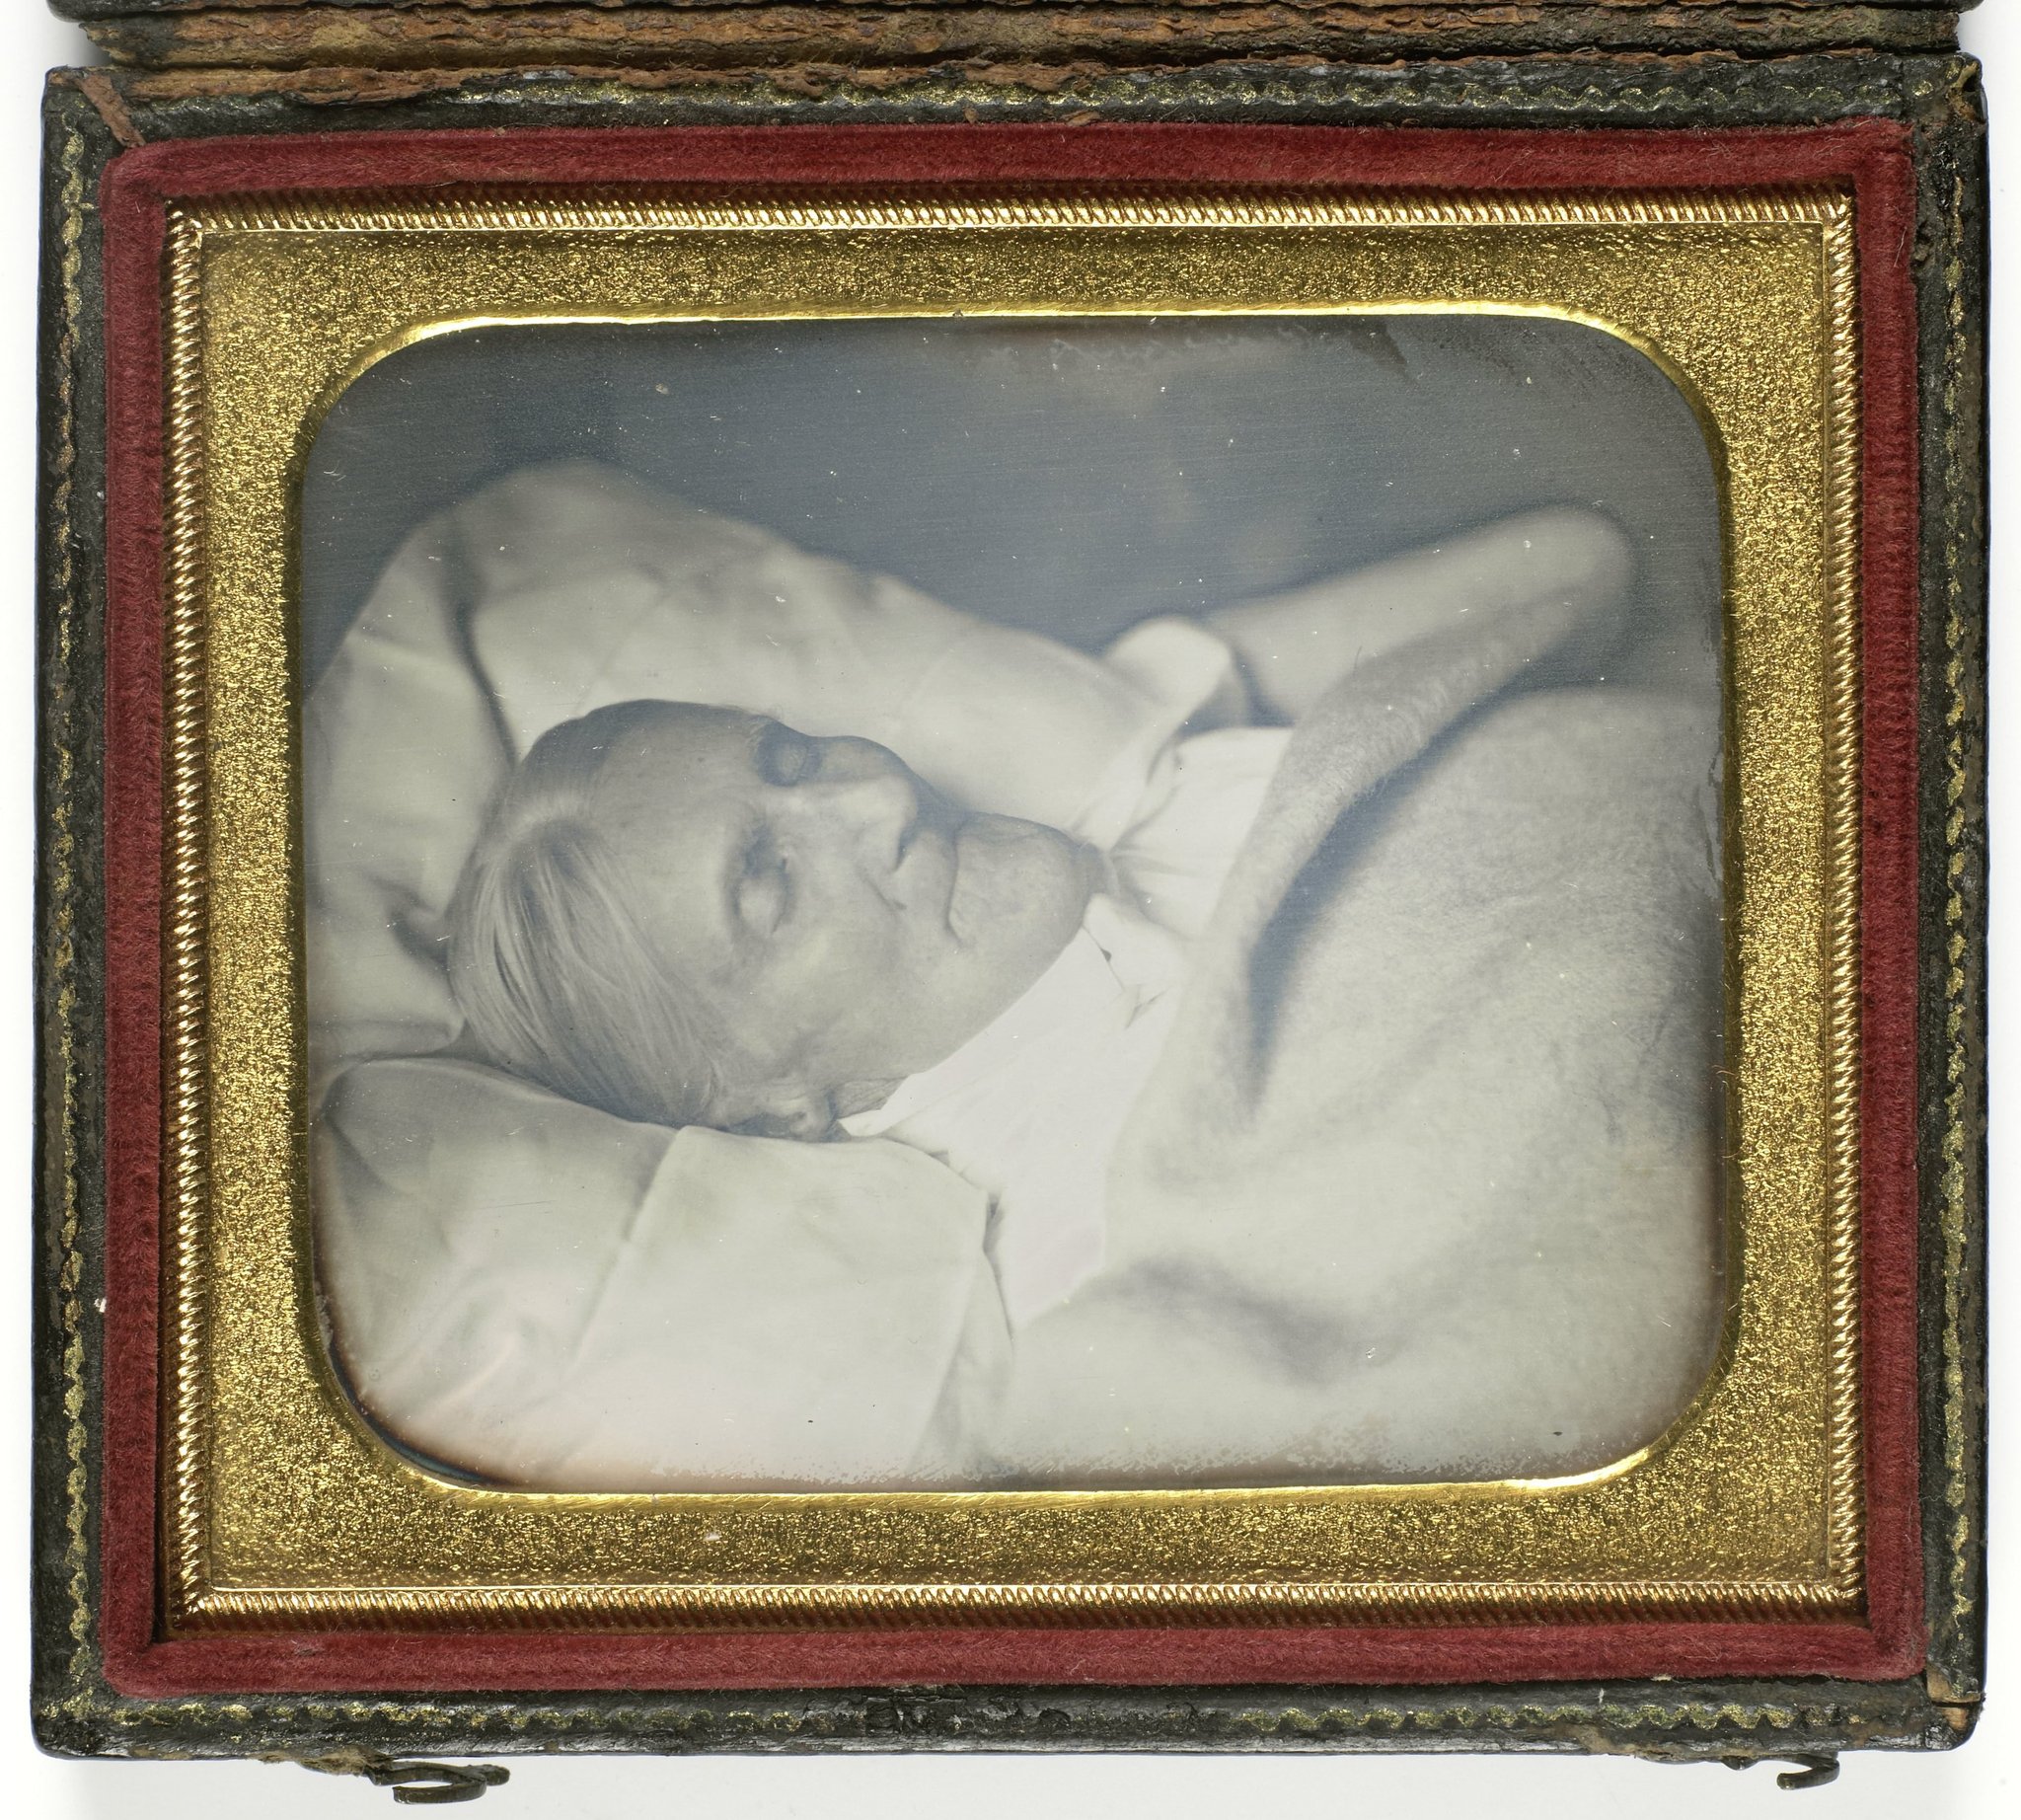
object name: photograph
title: Post-mortemportret van een onbekende oude vrouw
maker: Anonymous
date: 1850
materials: copper, glass, leather, velvet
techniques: daguerreotype, hand coloring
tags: adult woman, historical persons, the corpse